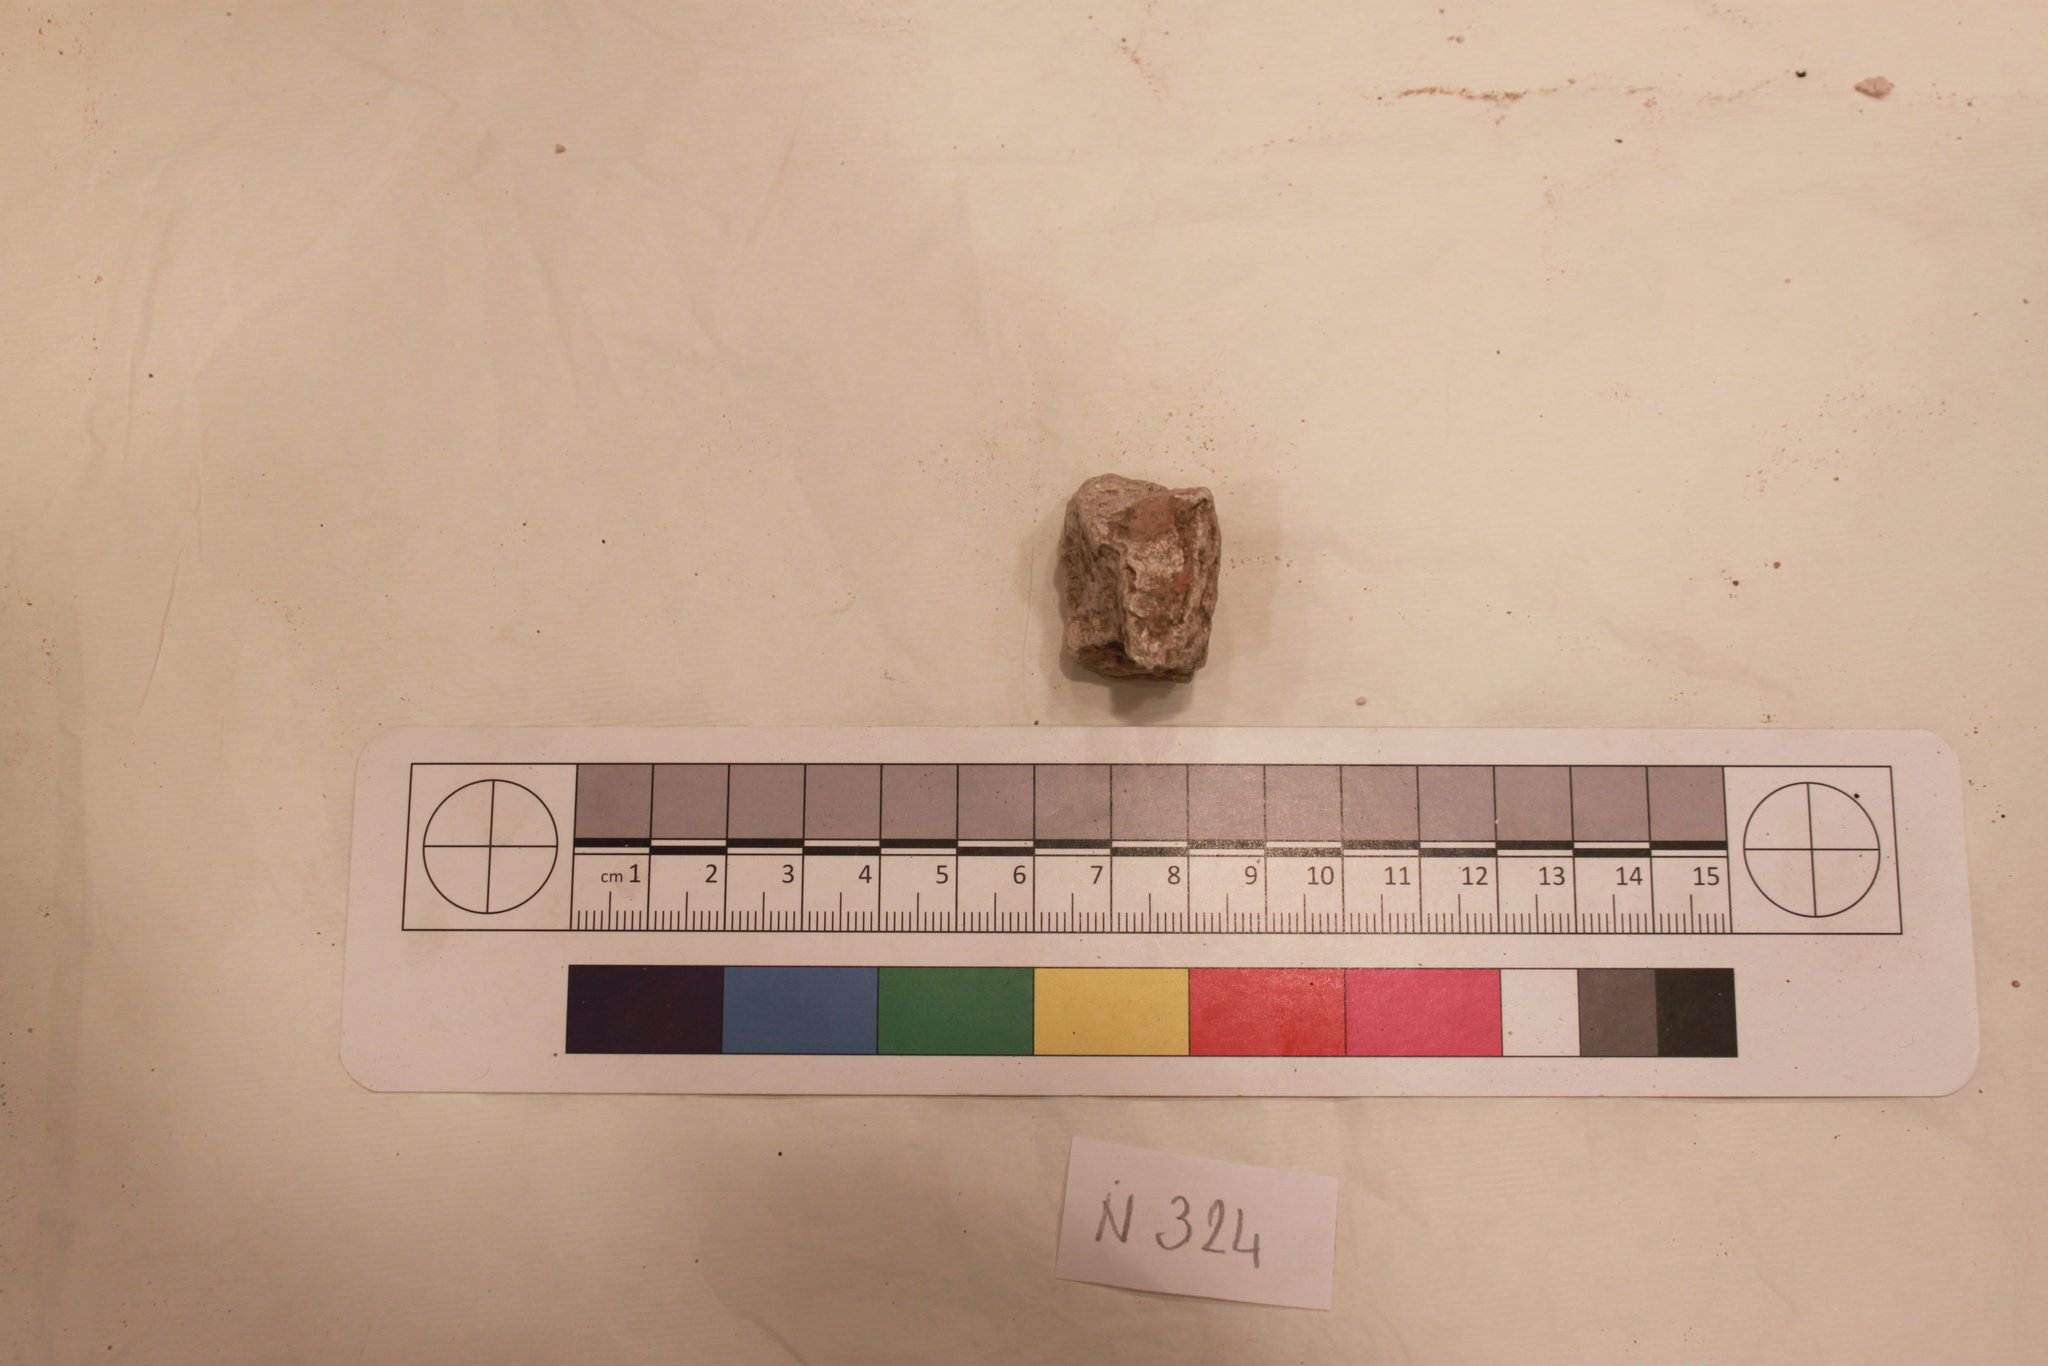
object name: fragment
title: Stucco Fragment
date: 701-1200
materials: plaster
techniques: carving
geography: iran